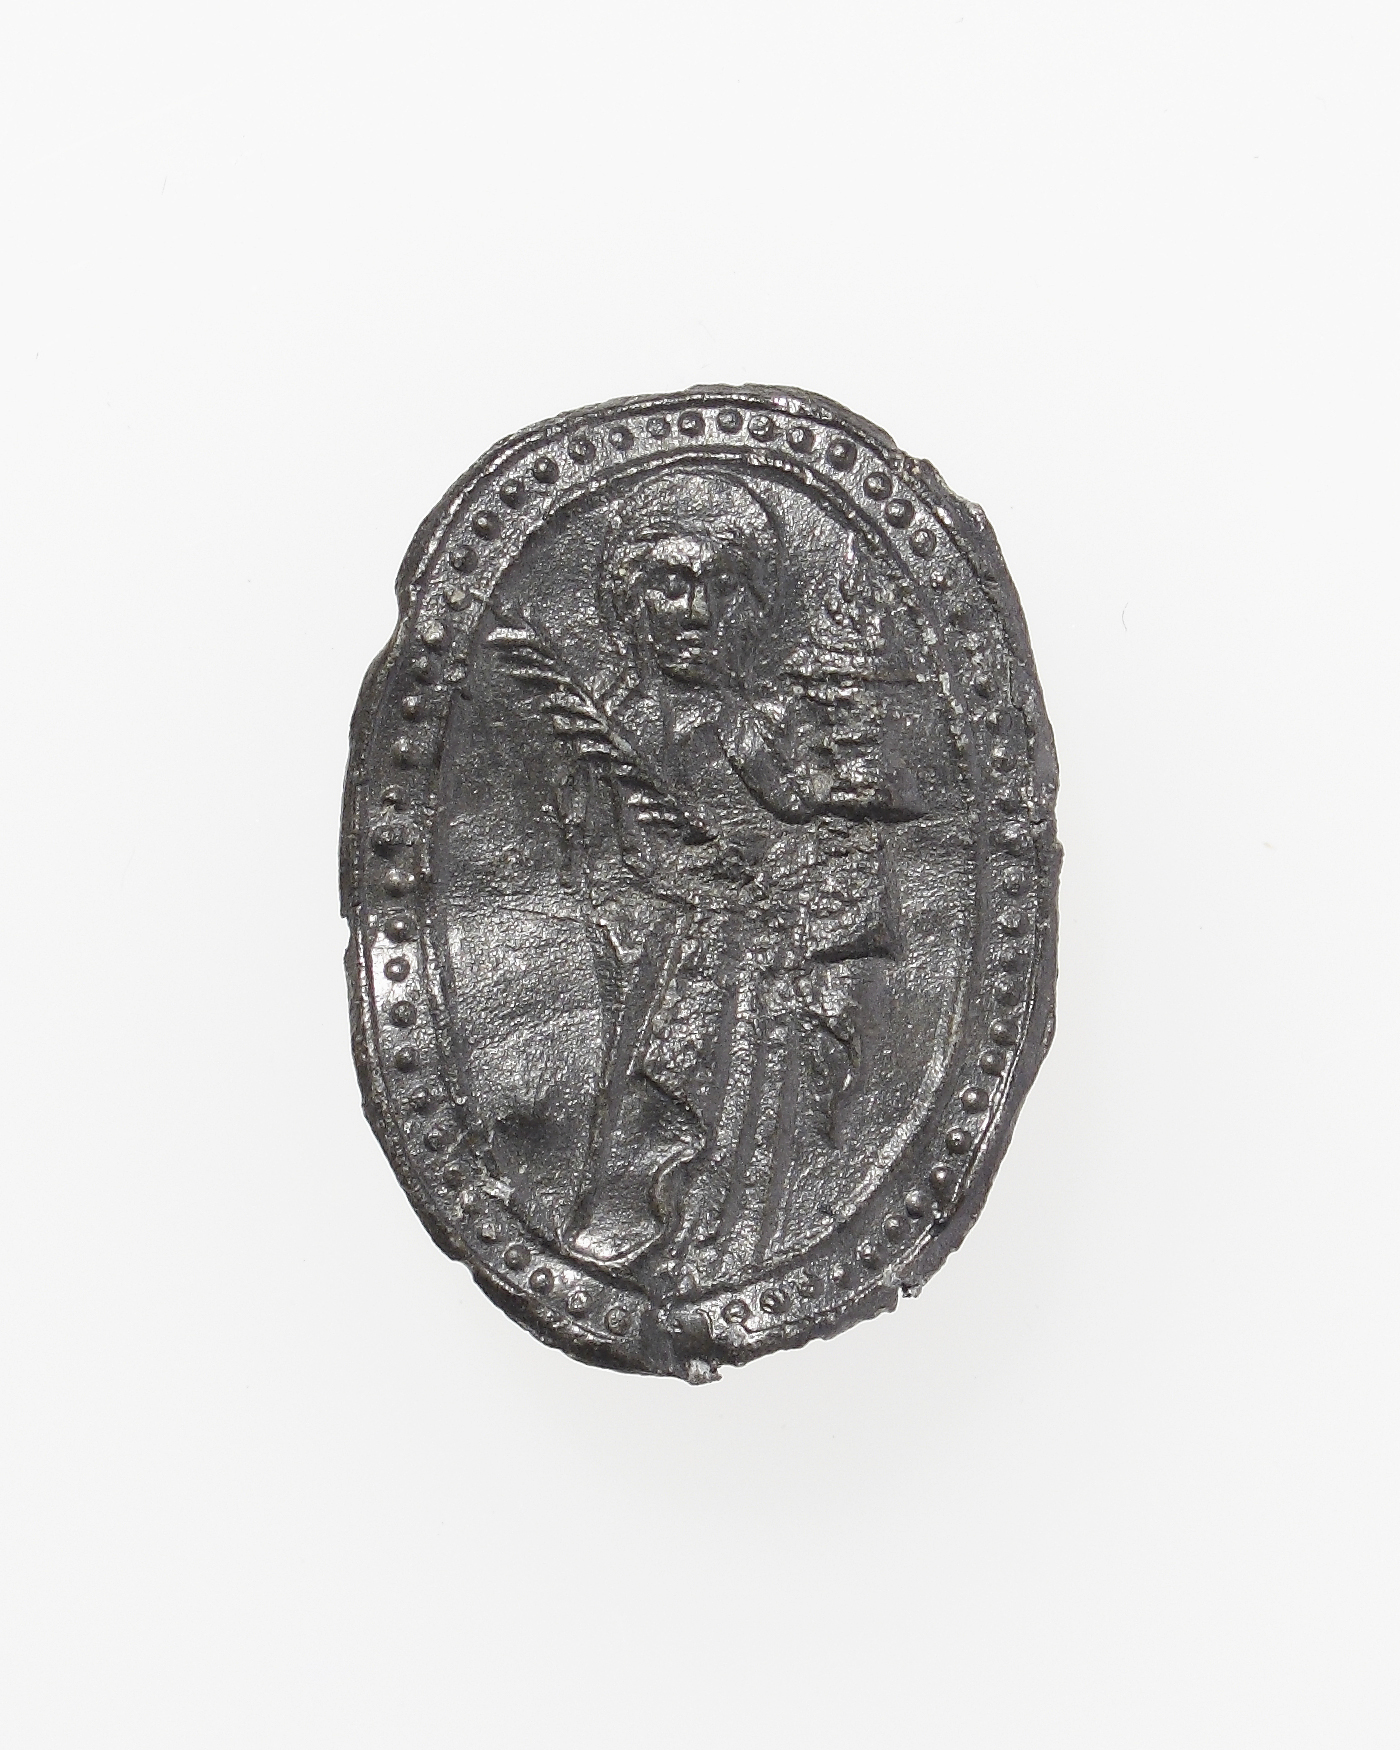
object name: pilgrim's badge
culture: french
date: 1301-1600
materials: lead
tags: saints